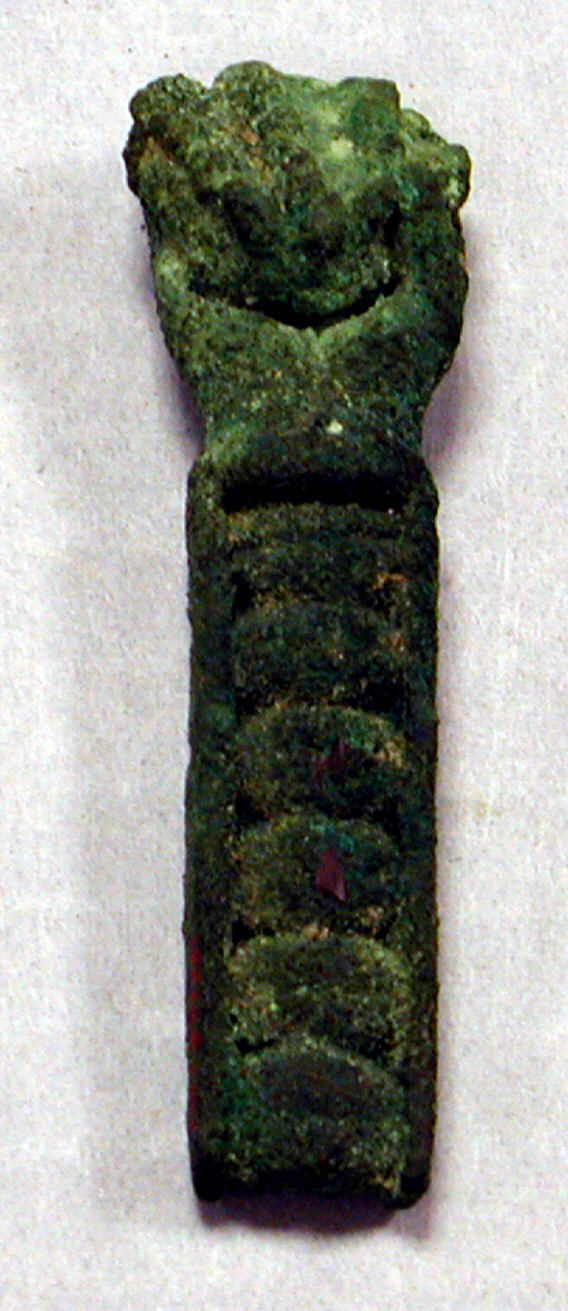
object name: knife fragment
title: Tumi Fragment with Fist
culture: moche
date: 101-700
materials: copper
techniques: casting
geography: peru